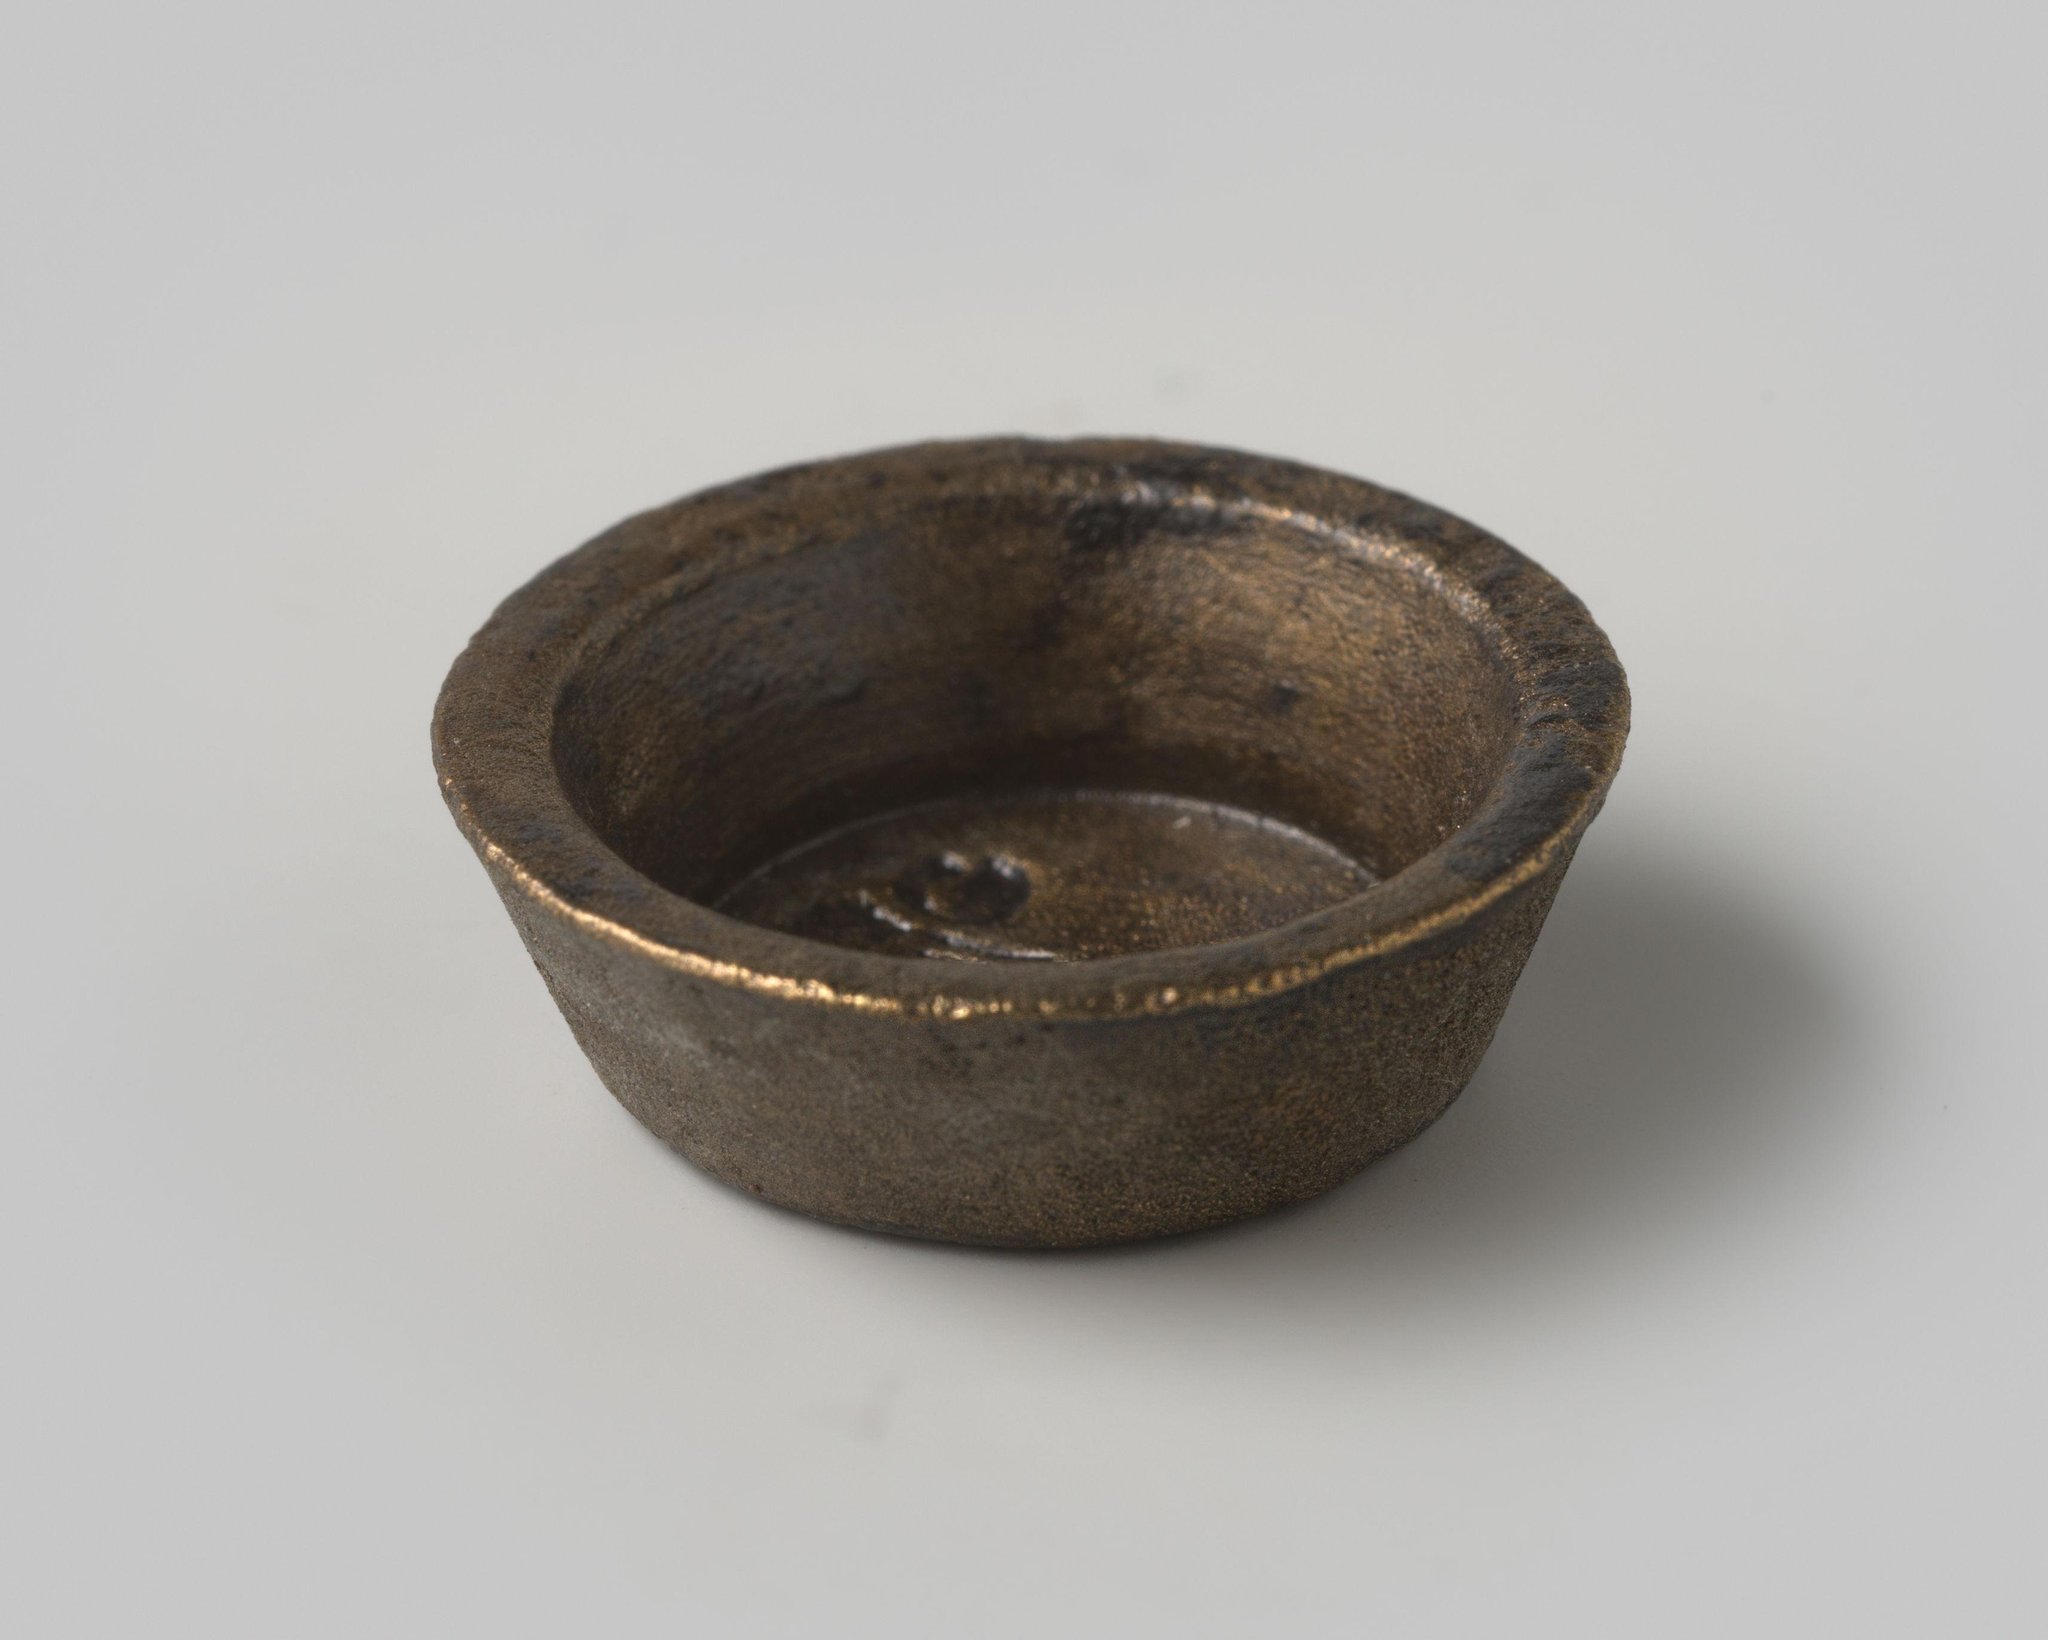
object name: weight scale component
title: Gewicht van sluitgewicht uit het wrak van de Oost-Indiëvaarder Hollandia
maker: Anonymous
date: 1700-1743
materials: copper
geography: netherlands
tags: verenigde oostindische compagnie, hollandia (schip), annet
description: Weight, cupweight, cup; id. NG 1980-27H2775, id. mark.